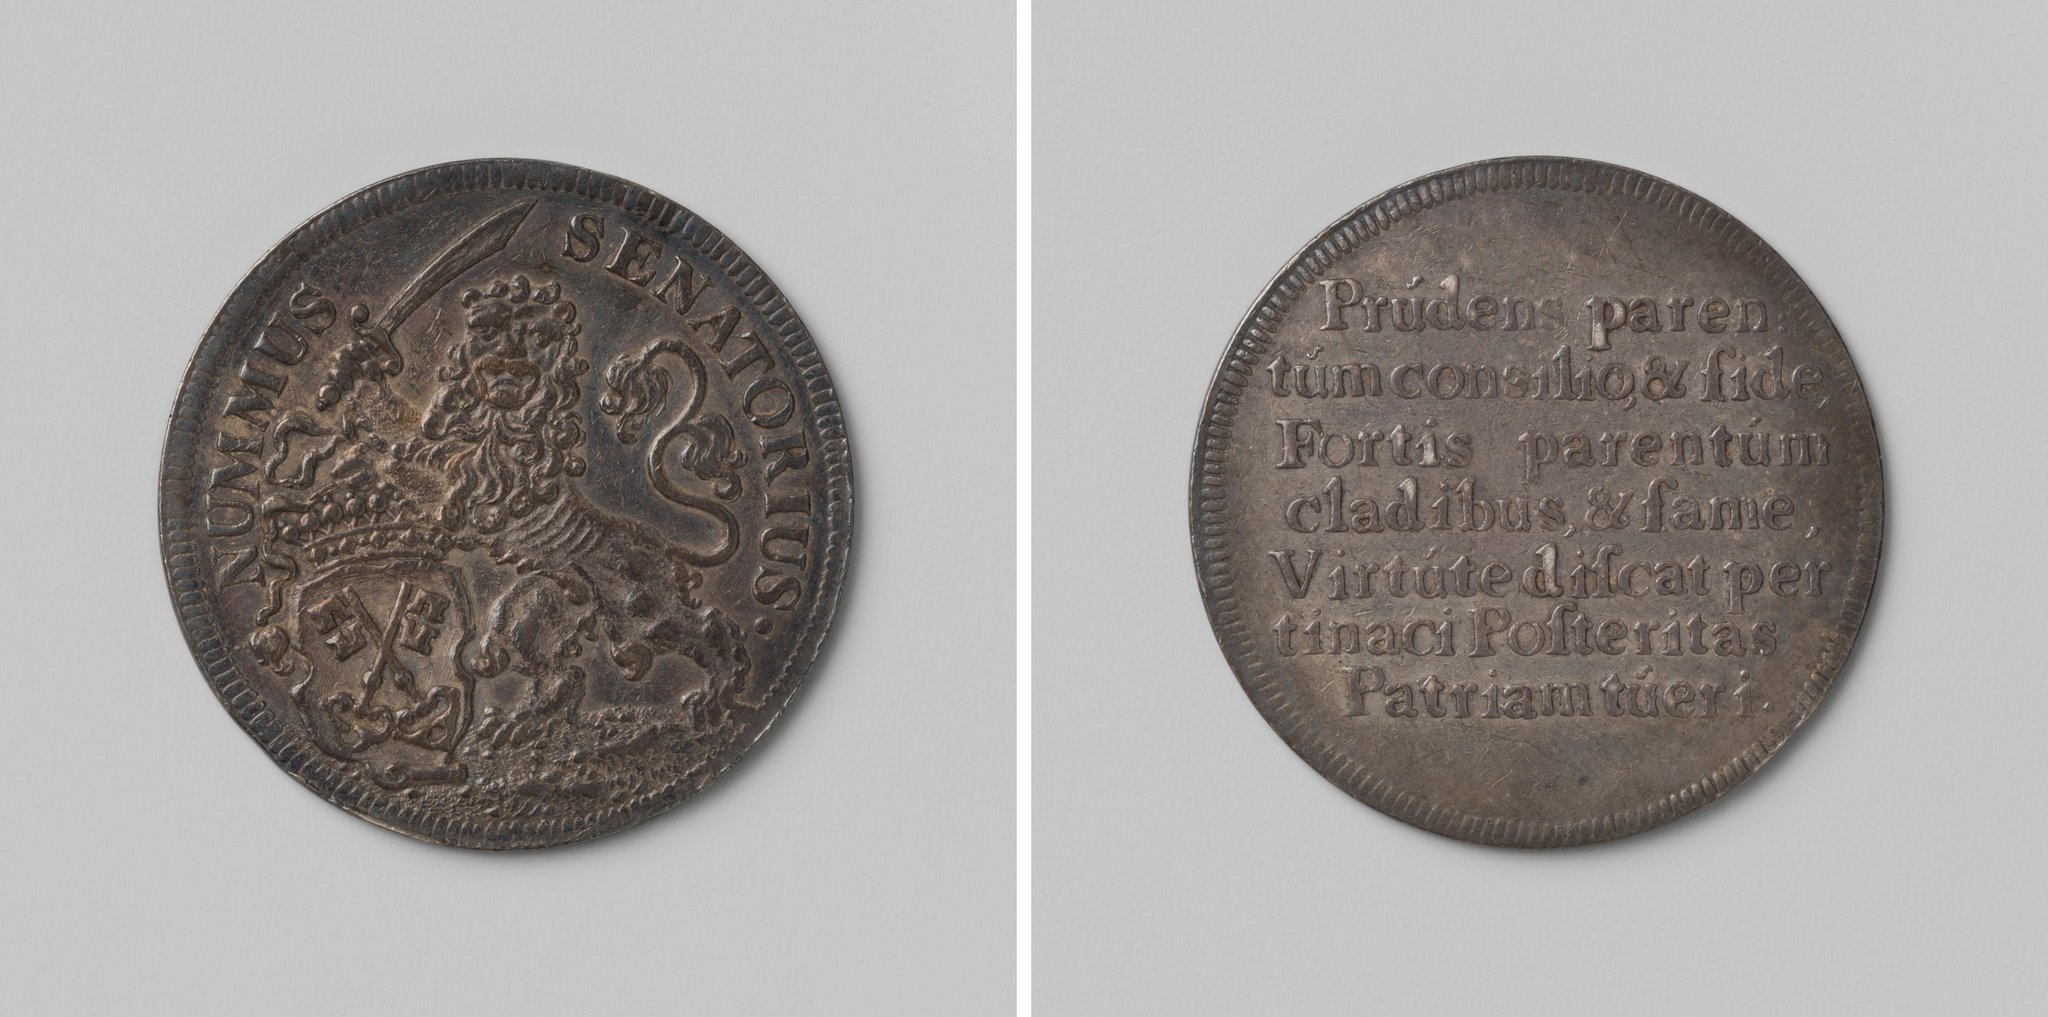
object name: council medal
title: Vroedschapspenning van de stad Leiden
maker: Anonymous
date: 1671-1723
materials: silver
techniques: striking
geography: leiden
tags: leiden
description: Zilveren penning. Voorzijde: leeuw met kop en face en twee pluimen in staart houdt zwaard in geheven rechter- en wapenschild aan lint in linkerklauw binnen omschrift en kartelrand. Keerzijde: opschrift binnen kartelrand